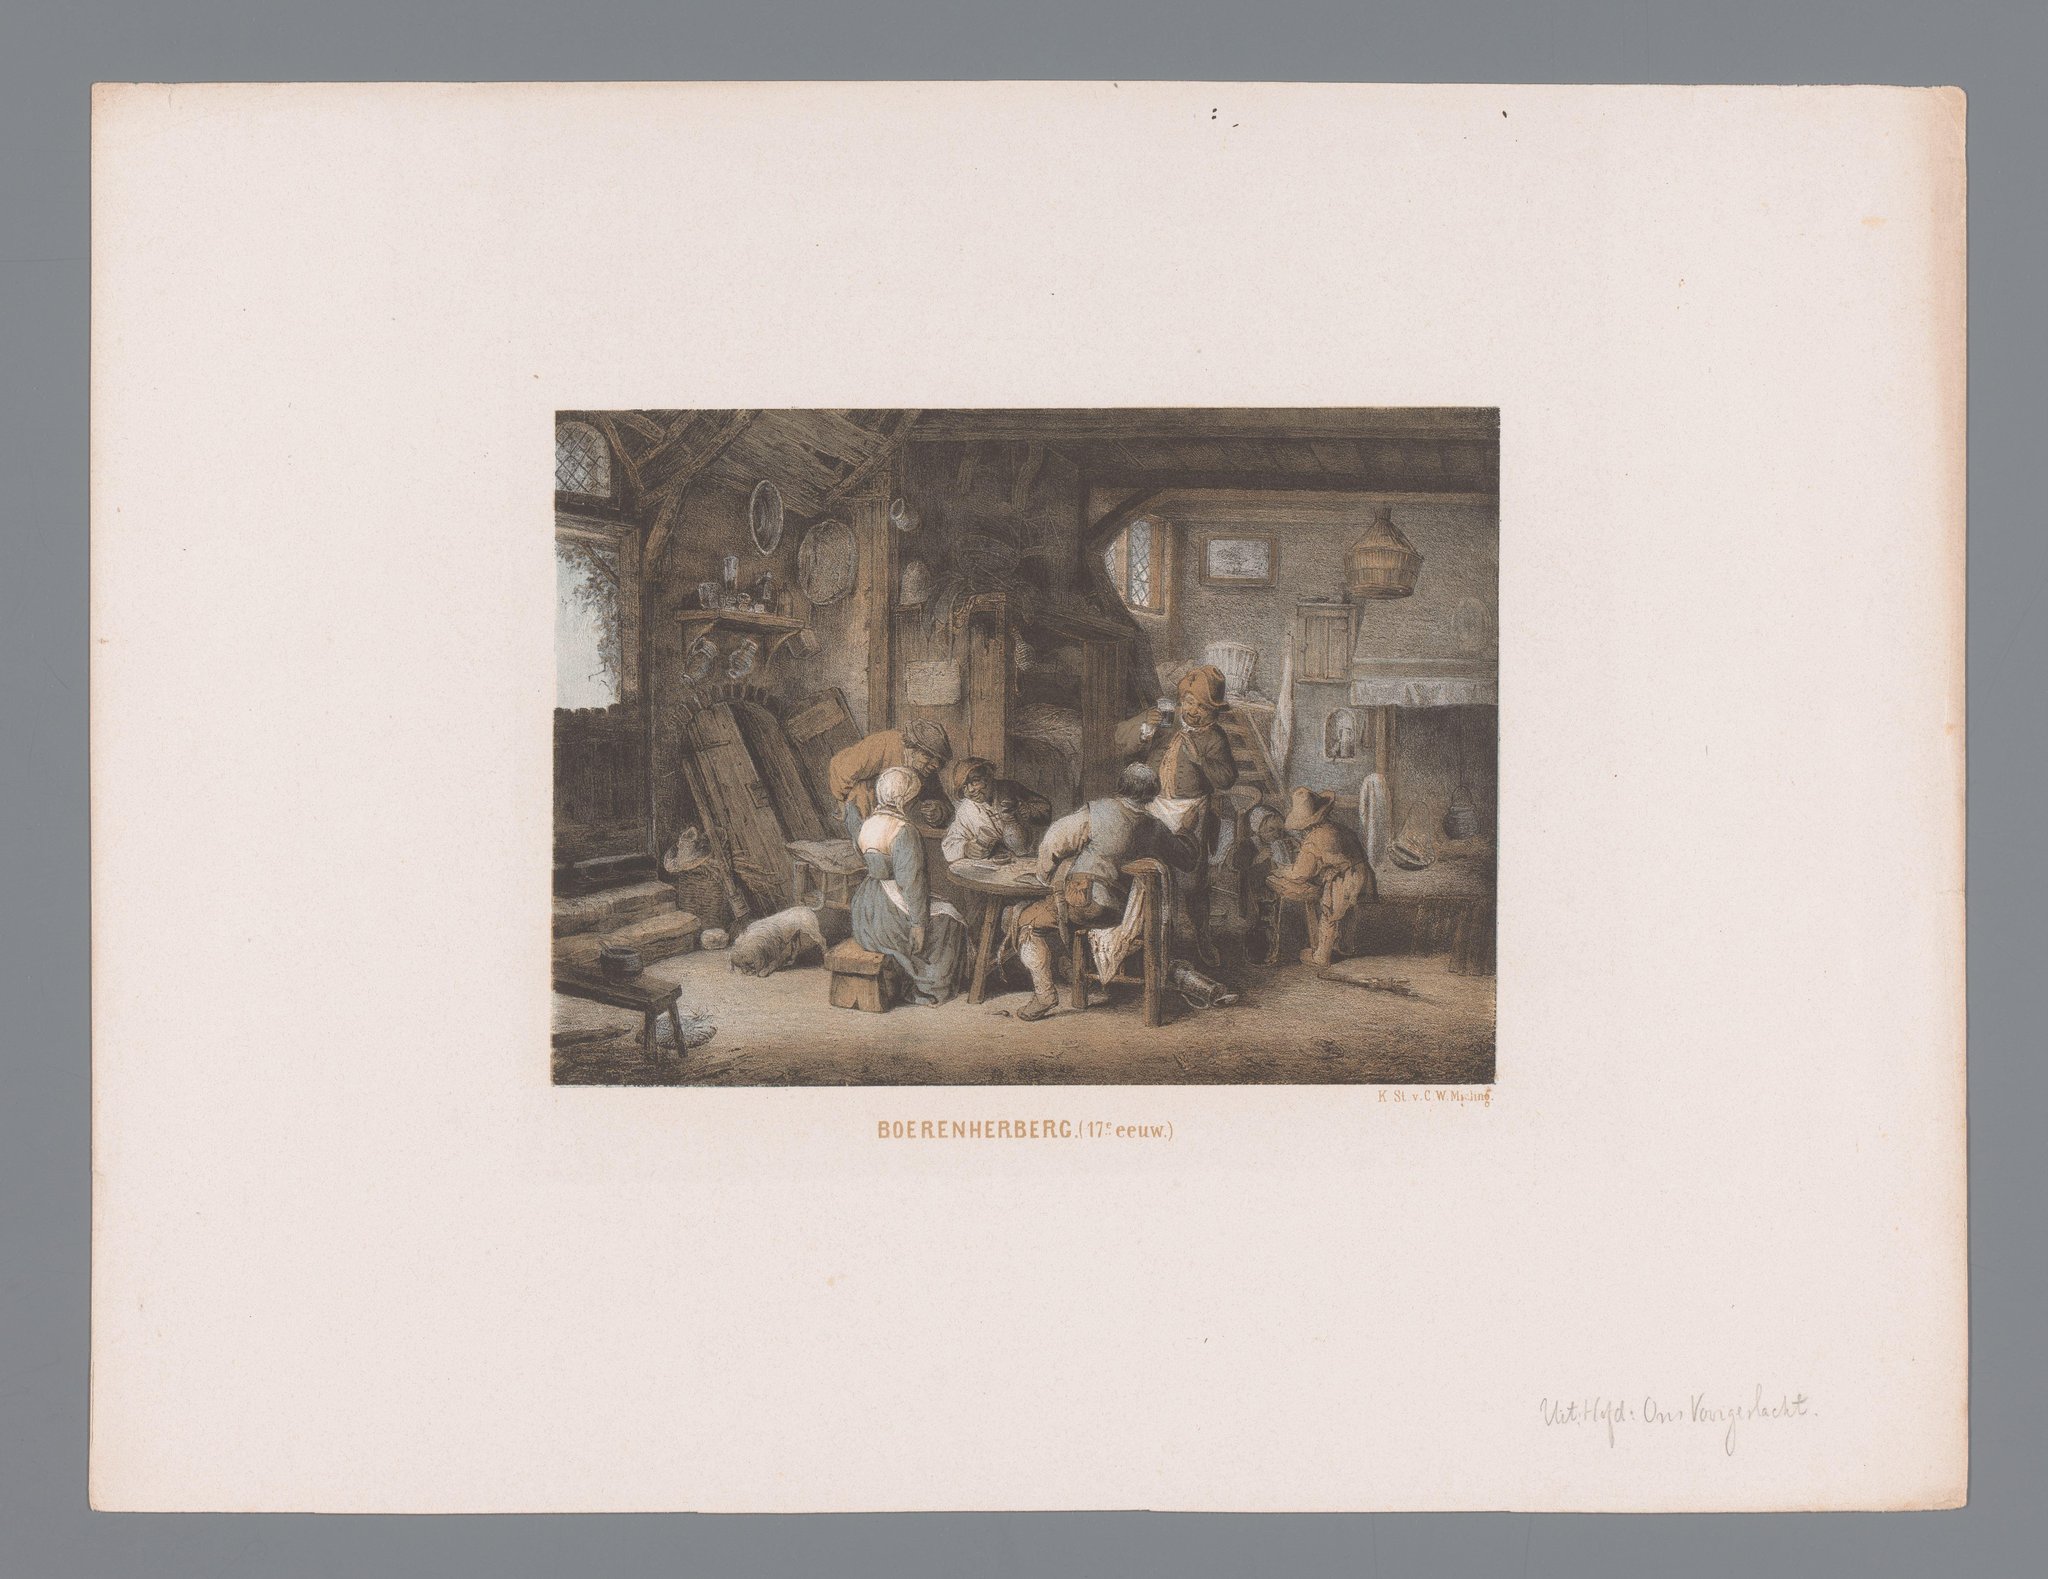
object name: print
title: Drinkend gezelschap in een herberg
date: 1864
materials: paper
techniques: tone lithography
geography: haarlem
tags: inn, coffee-house, public house, etc., drunkenness, drinking, hotel, hostelry, inn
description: De mannen en vrouwen zitten aan tafel, rechts twee kinderen.